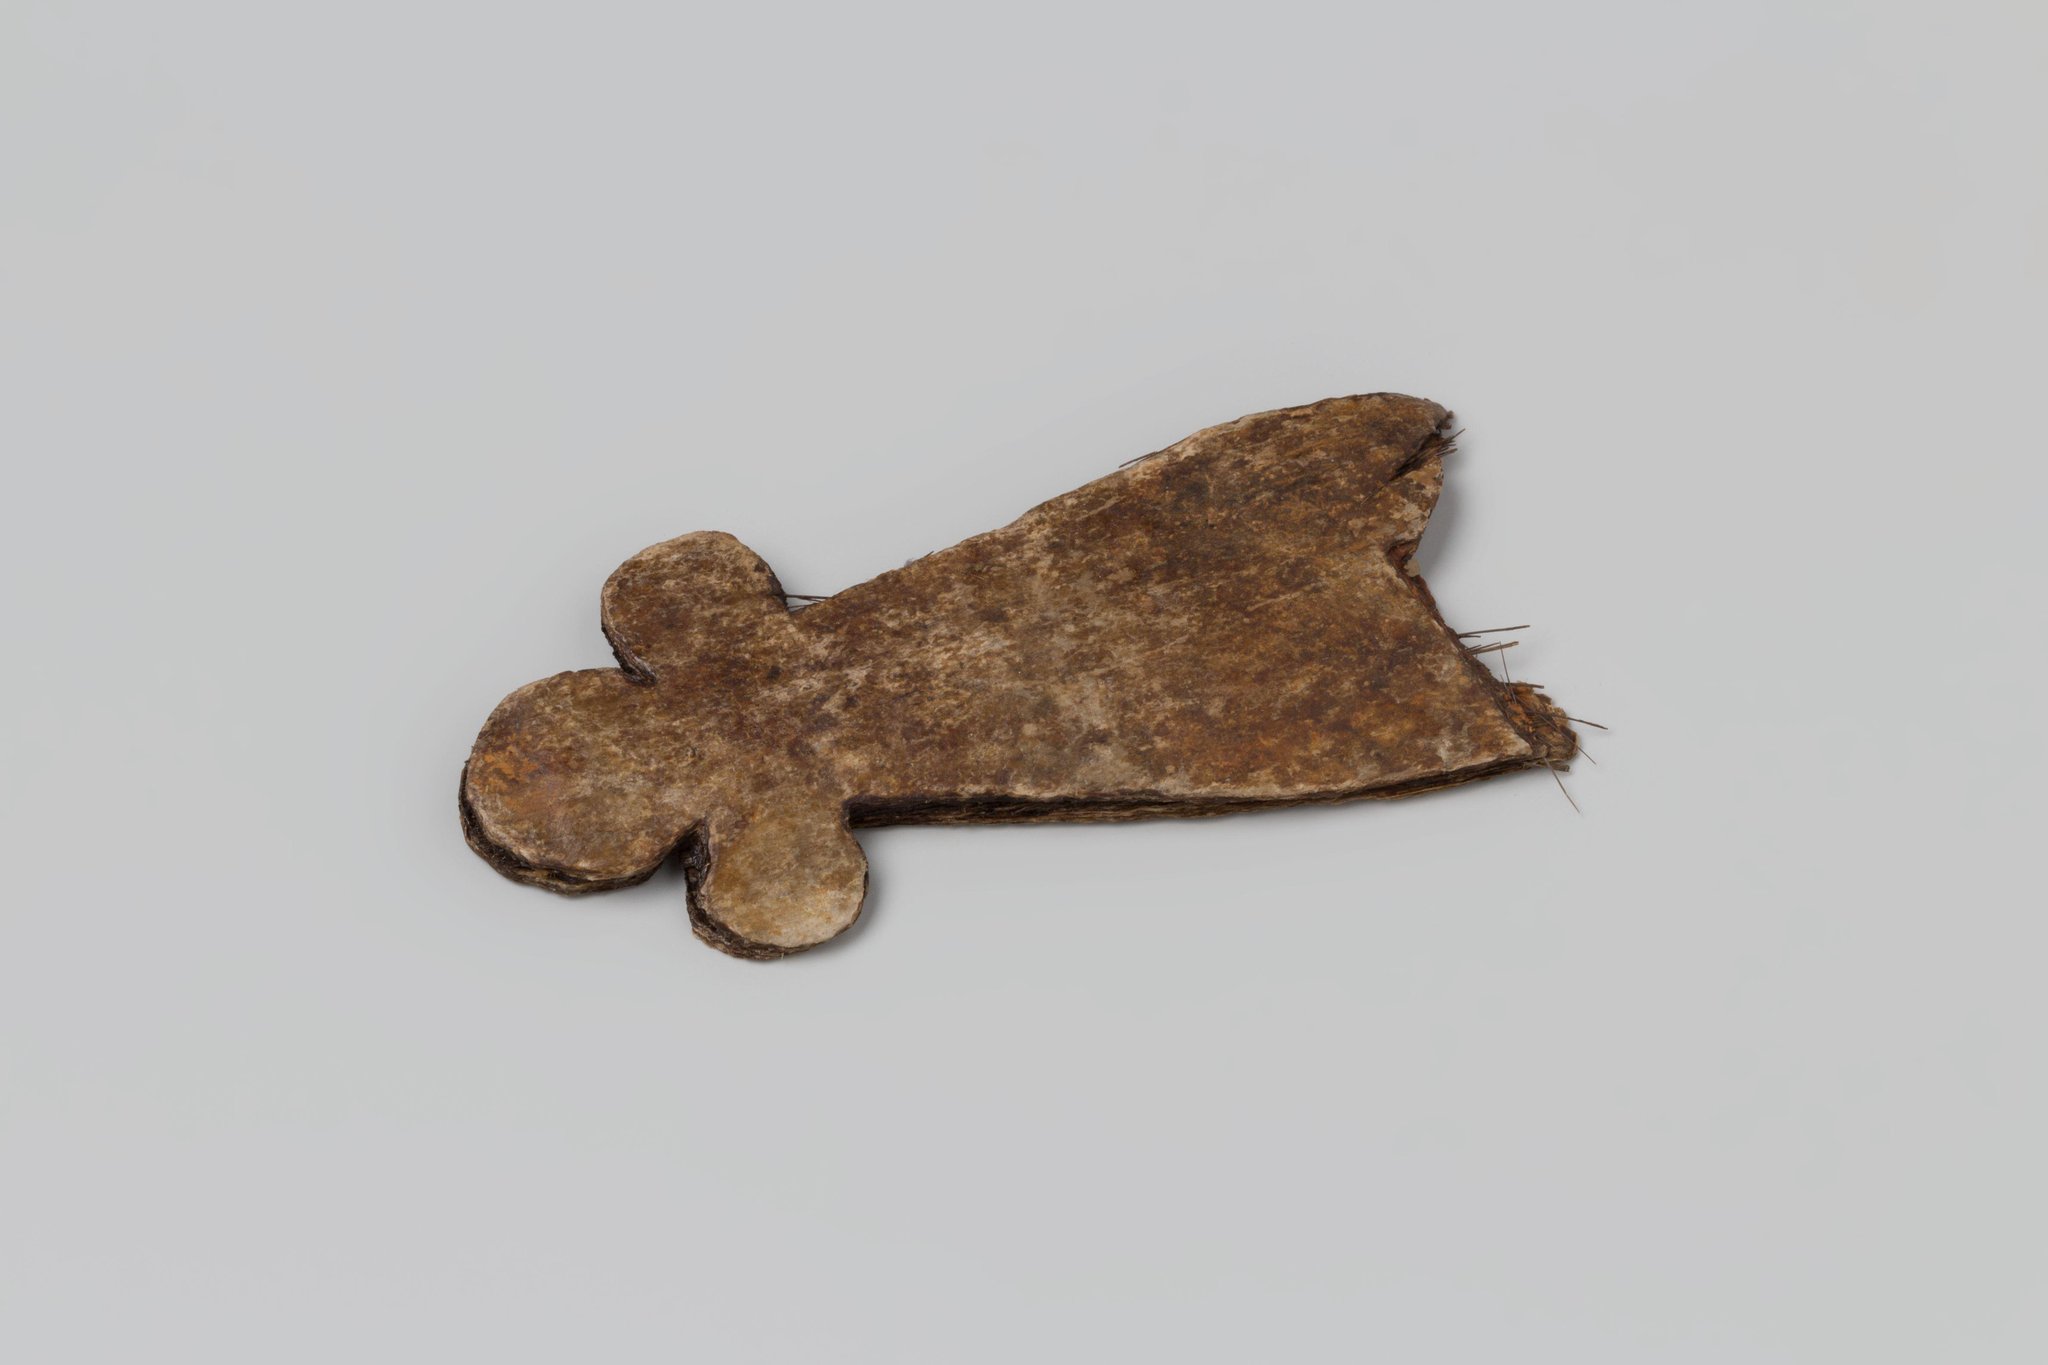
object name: reception piece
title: Proefstuk met balein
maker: Anonymous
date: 1400-1950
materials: baleen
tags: zeeuwsche uytkyck